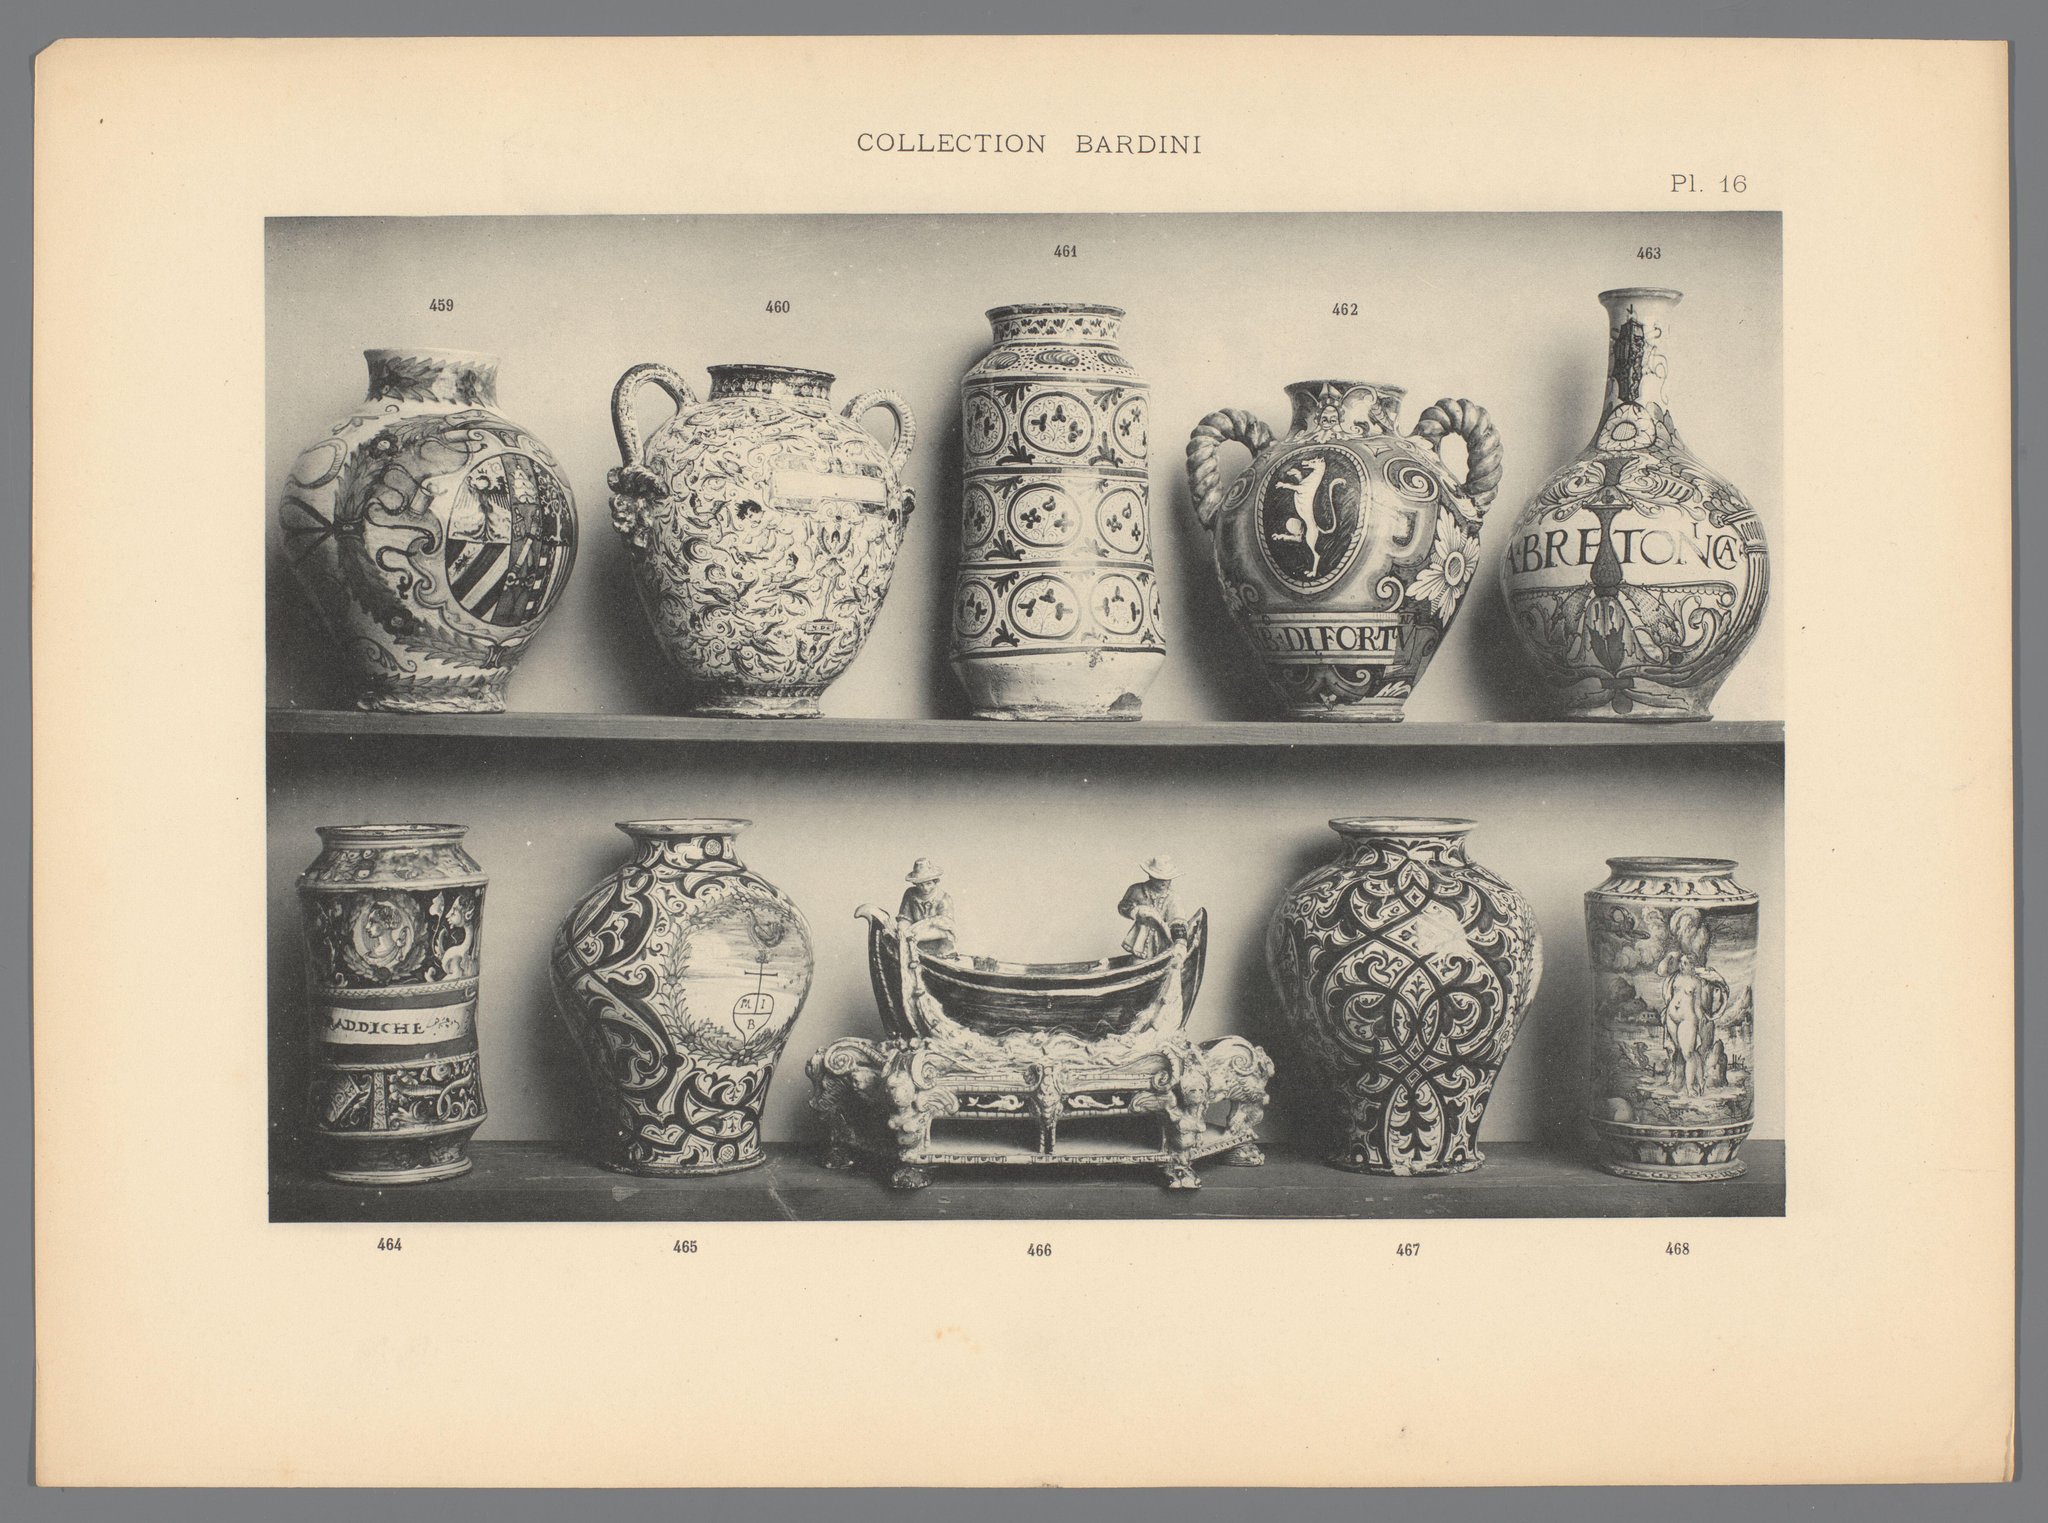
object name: photomechanical print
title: Verzameling gedecoreerde vazen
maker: Anonymous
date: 1875-1930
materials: paper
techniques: photograph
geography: florence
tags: container of ceramics: jar, jug, pot, vase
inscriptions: number: ‘Pl. 16’